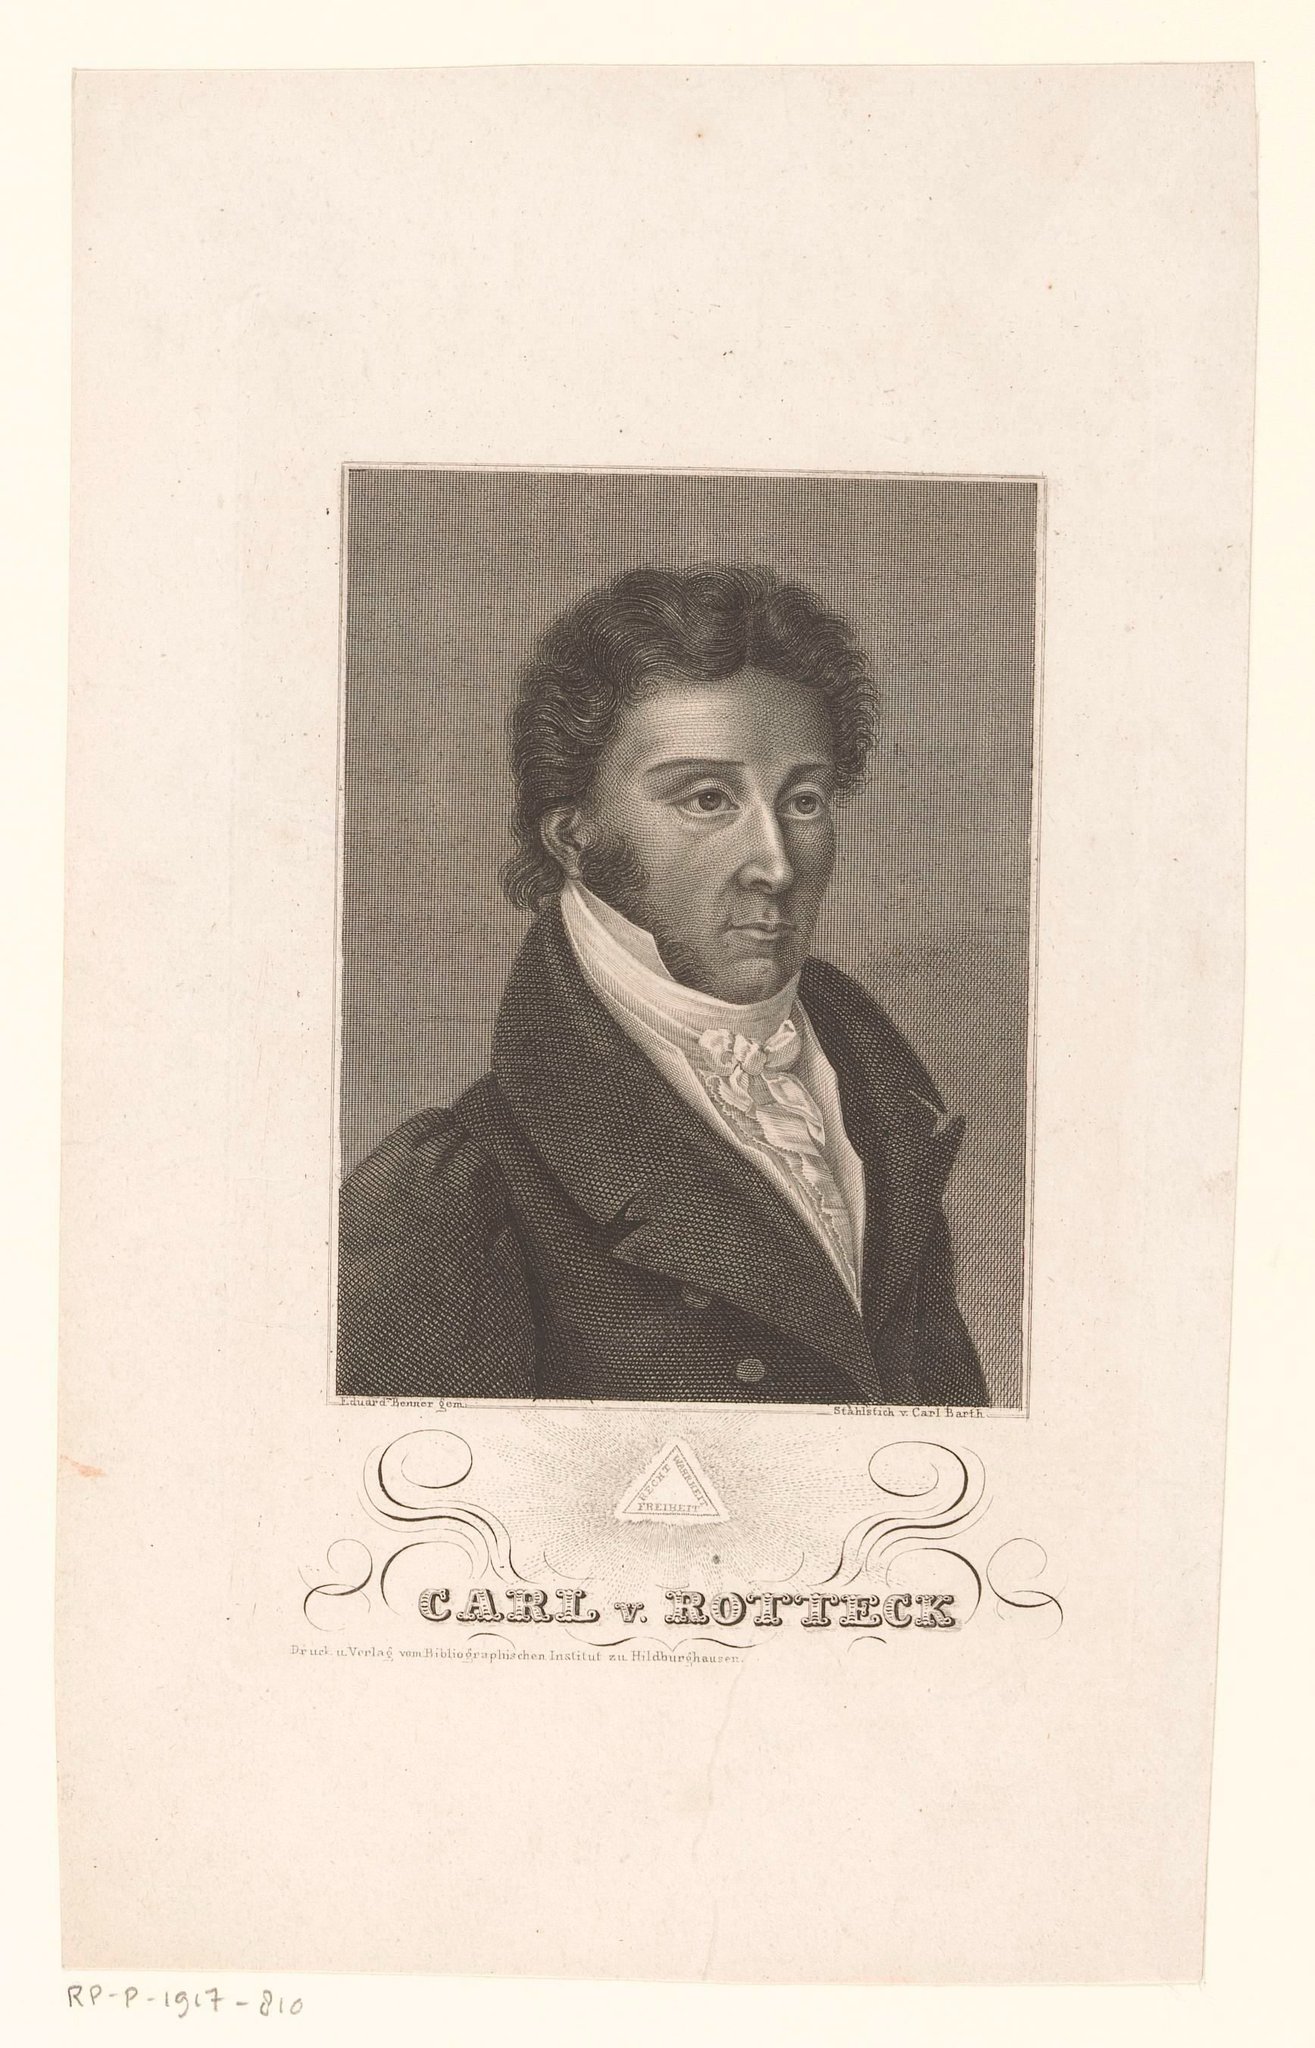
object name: print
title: Portret van Karl von Rotteck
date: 1828-1853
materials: paper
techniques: engraving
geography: hildburghausen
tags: historical persons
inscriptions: collector's mark: Lugt 2228